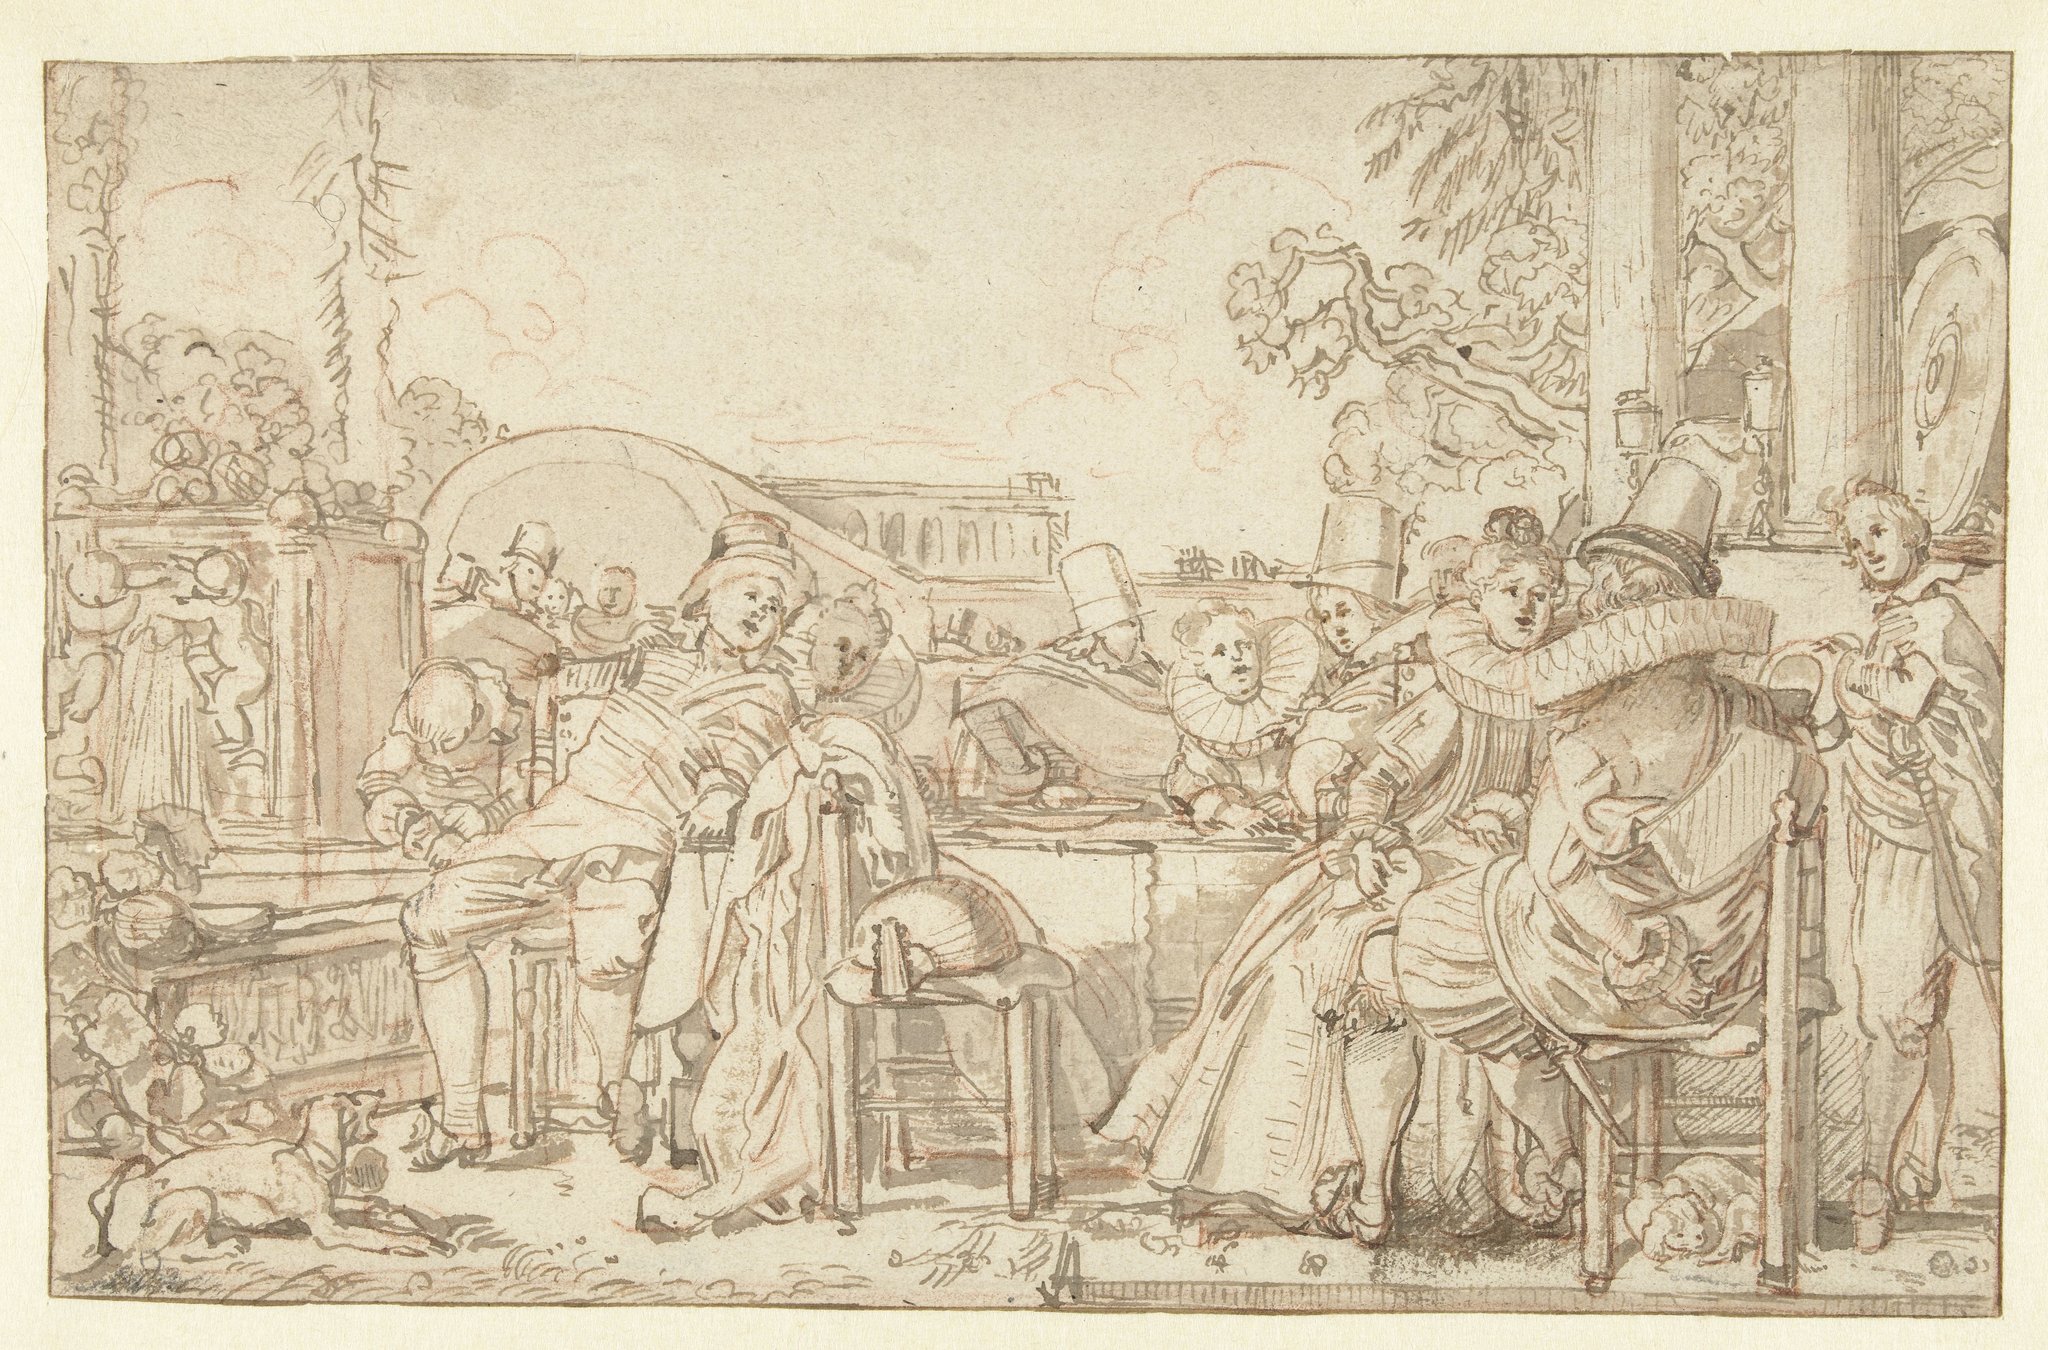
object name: drawing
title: Vrolijk gezelschap aan tafel in de open lucht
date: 1600-1699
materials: chalk, ink, paper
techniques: brush, pen